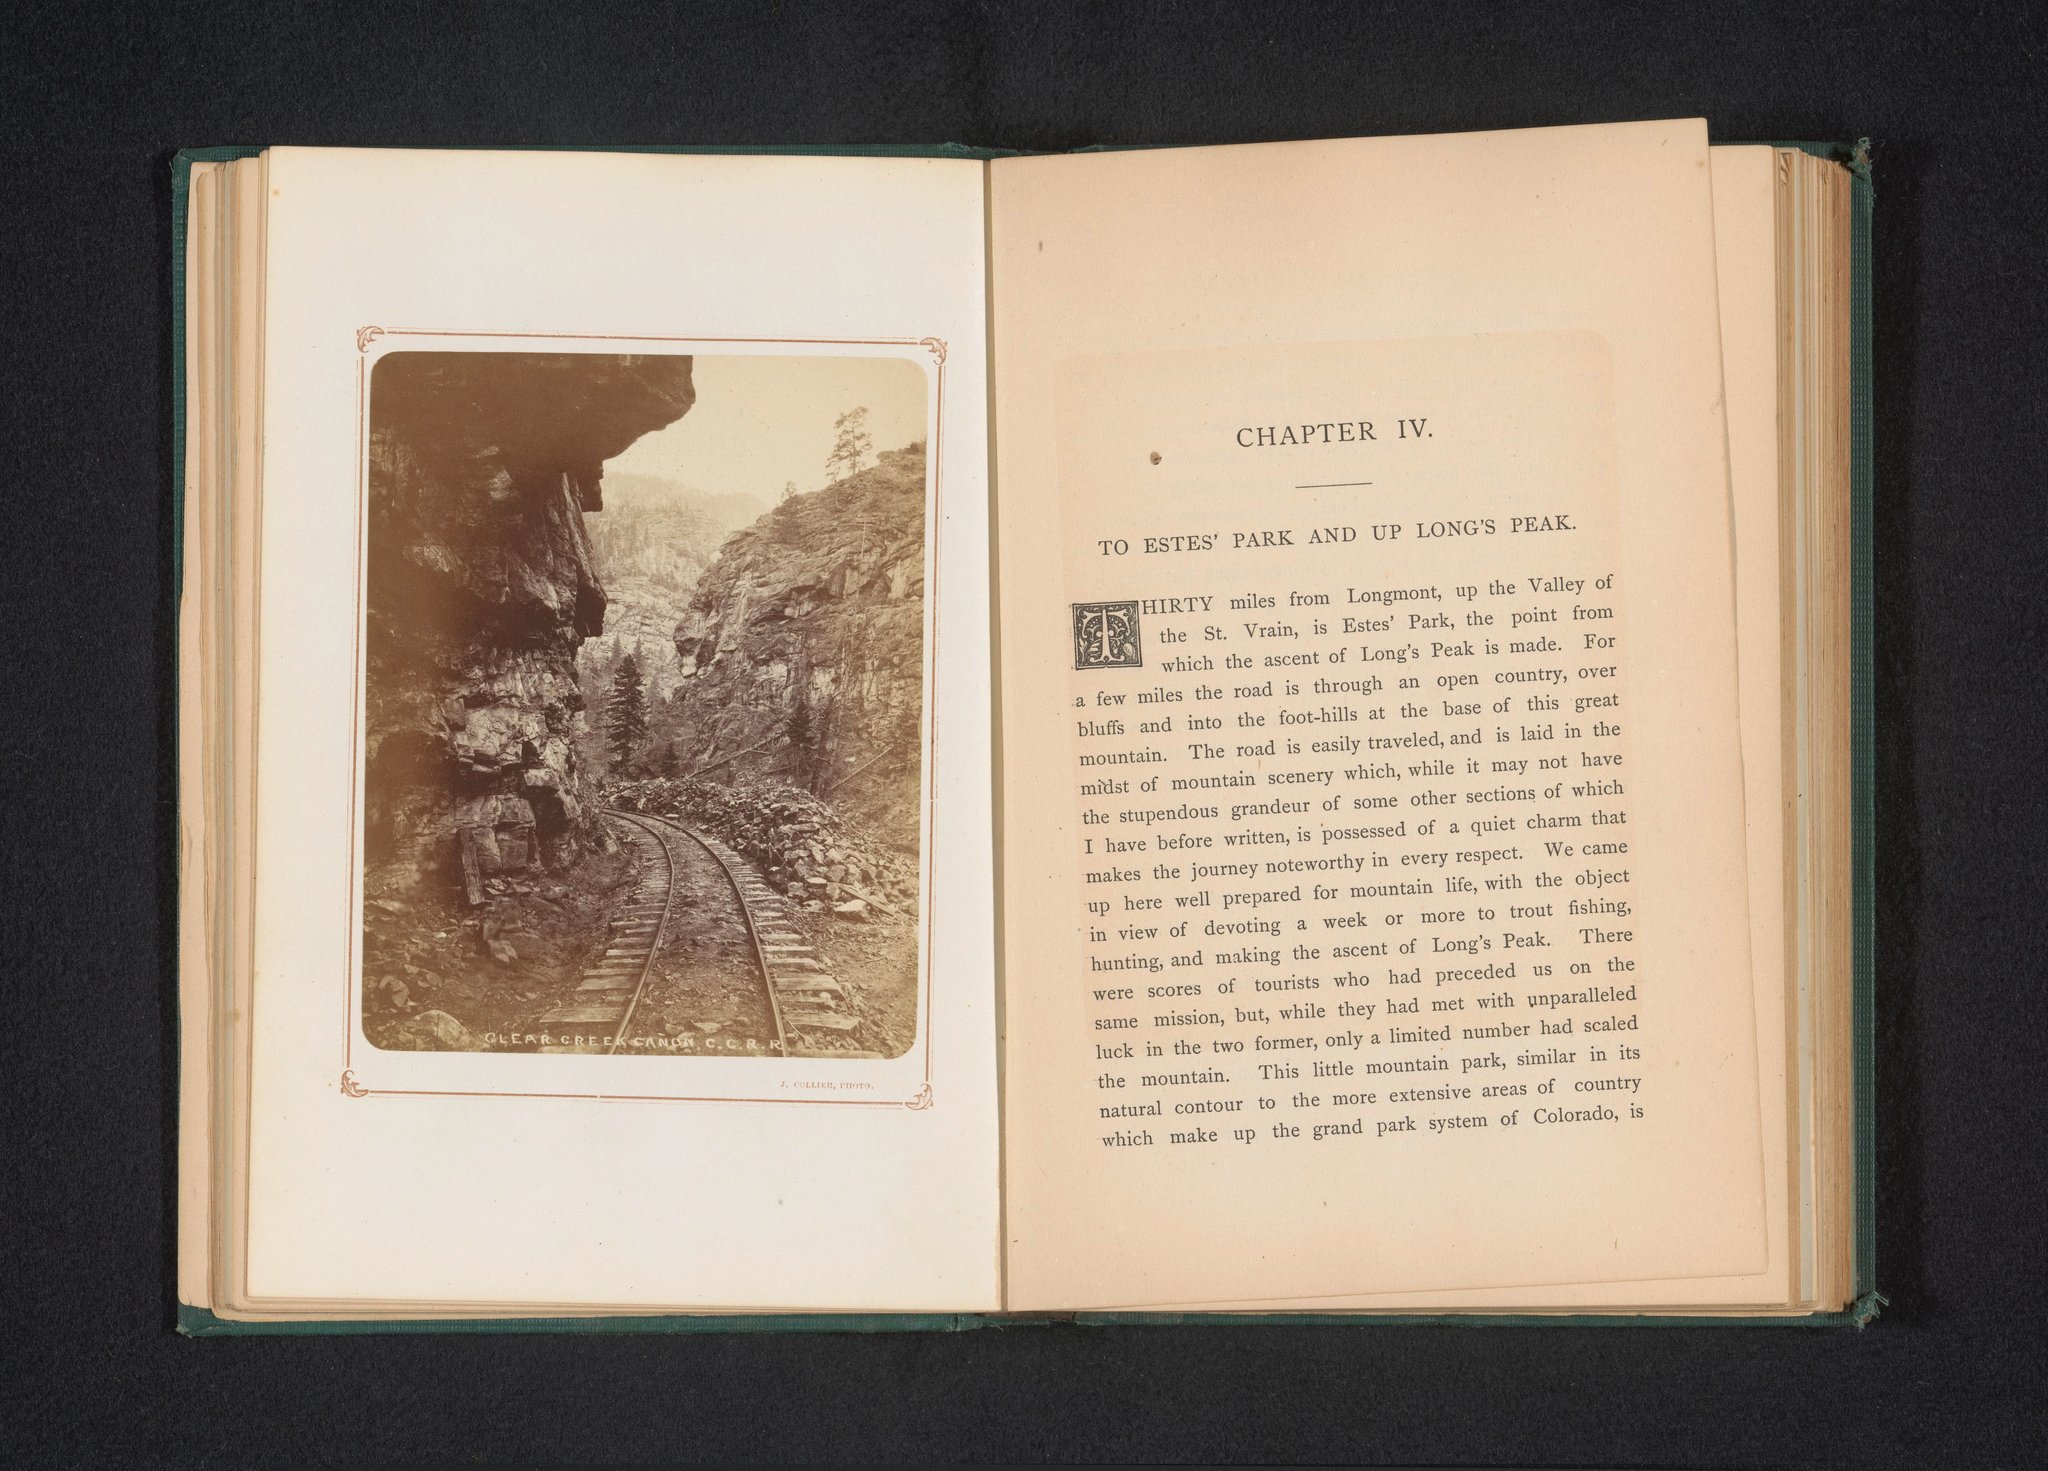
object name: page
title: Clear Creek Canon, C. C. R. R.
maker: joseph collier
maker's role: fotograaf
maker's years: 1836-1910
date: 1869-1874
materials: photographic support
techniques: albumen print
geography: clear creek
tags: railway, tramway; rack railway, mountains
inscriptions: inscription: ‘Clear Creek Canon, C.C. R.R.’